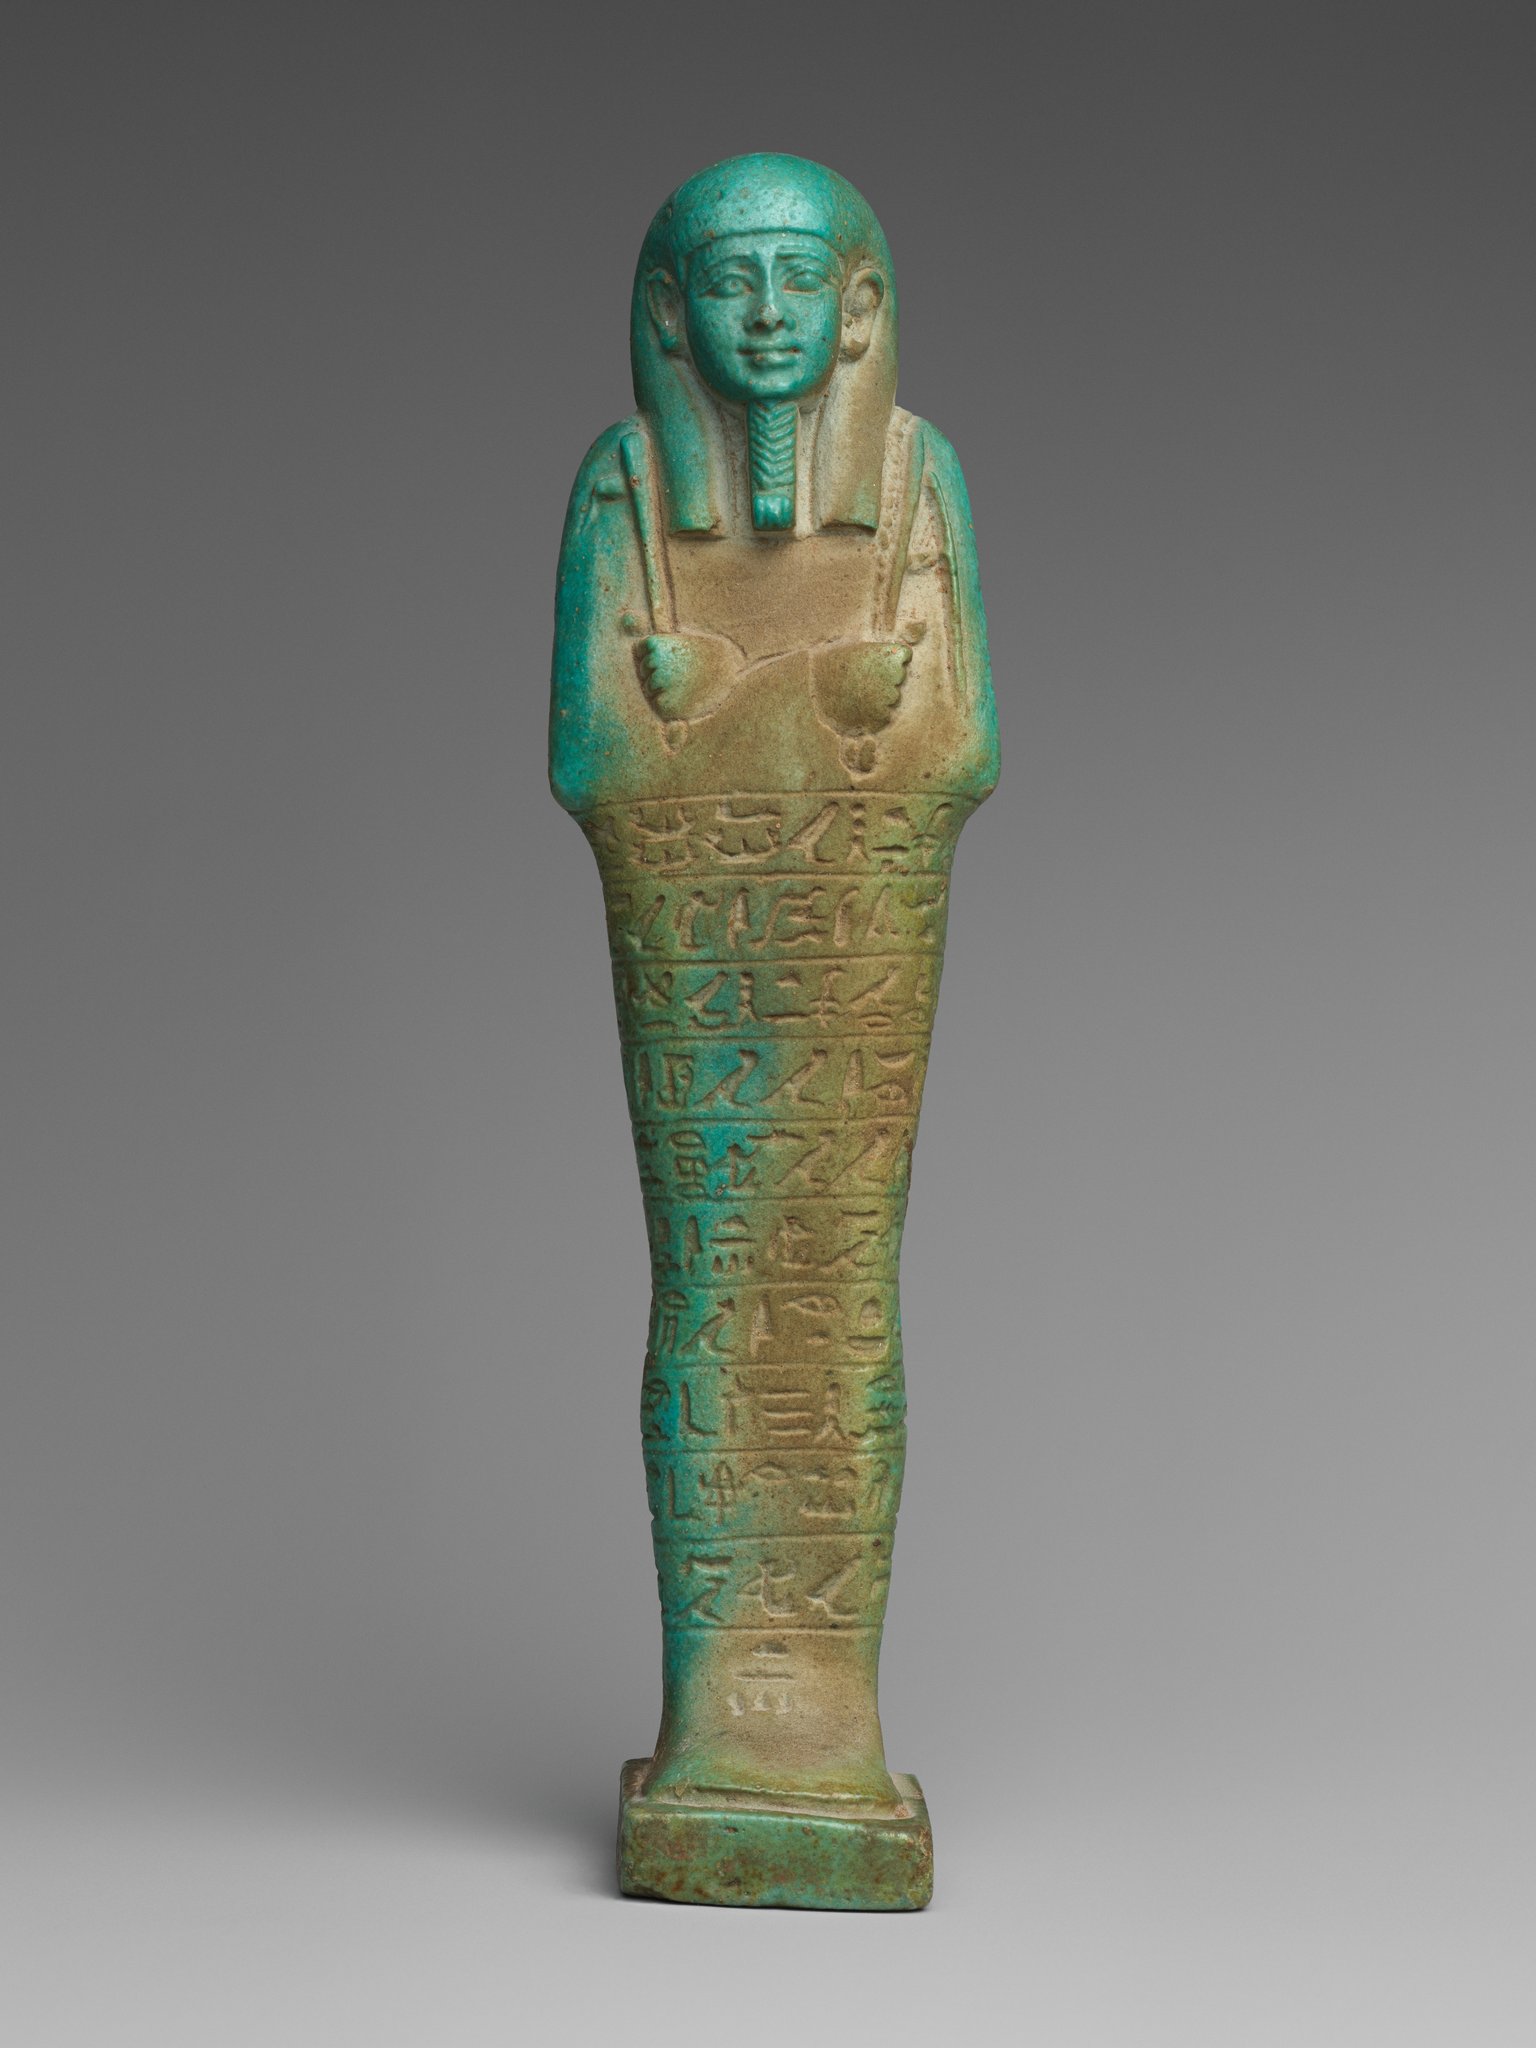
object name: shabti, tjanenhebu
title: Shabti of the Commander of the Royal Fleet Tjanenhebu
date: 570-526 BCE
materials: faience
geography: egypt